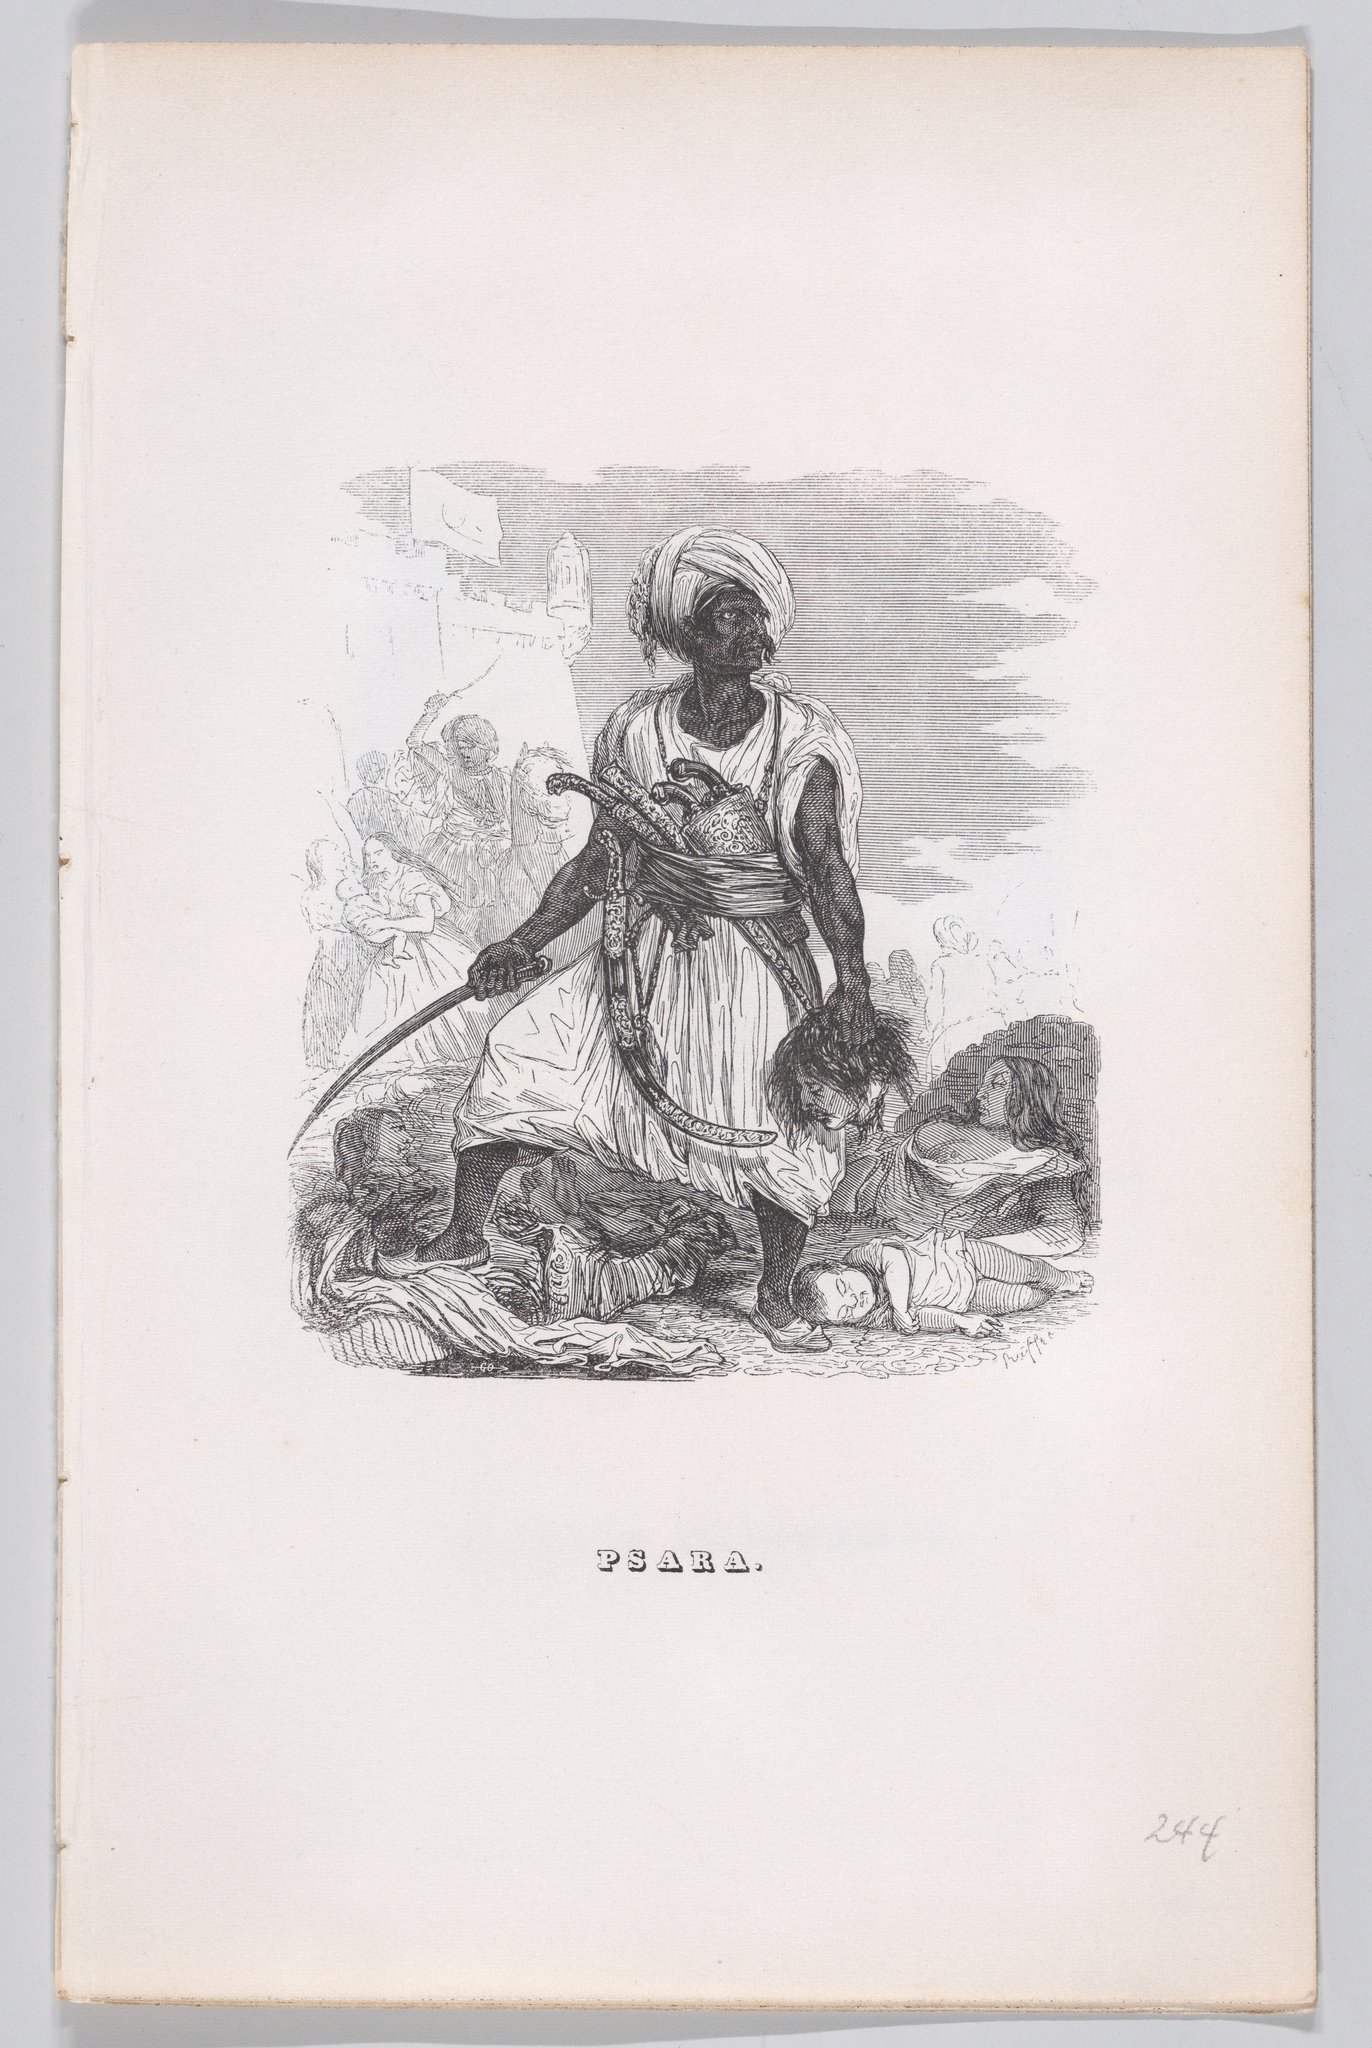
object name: print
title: Psara, from "The Complete Works of Béranger"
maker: j. j. grandville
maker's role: illustrator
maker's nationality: french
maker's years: 1803-1847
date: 1836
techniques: engraving